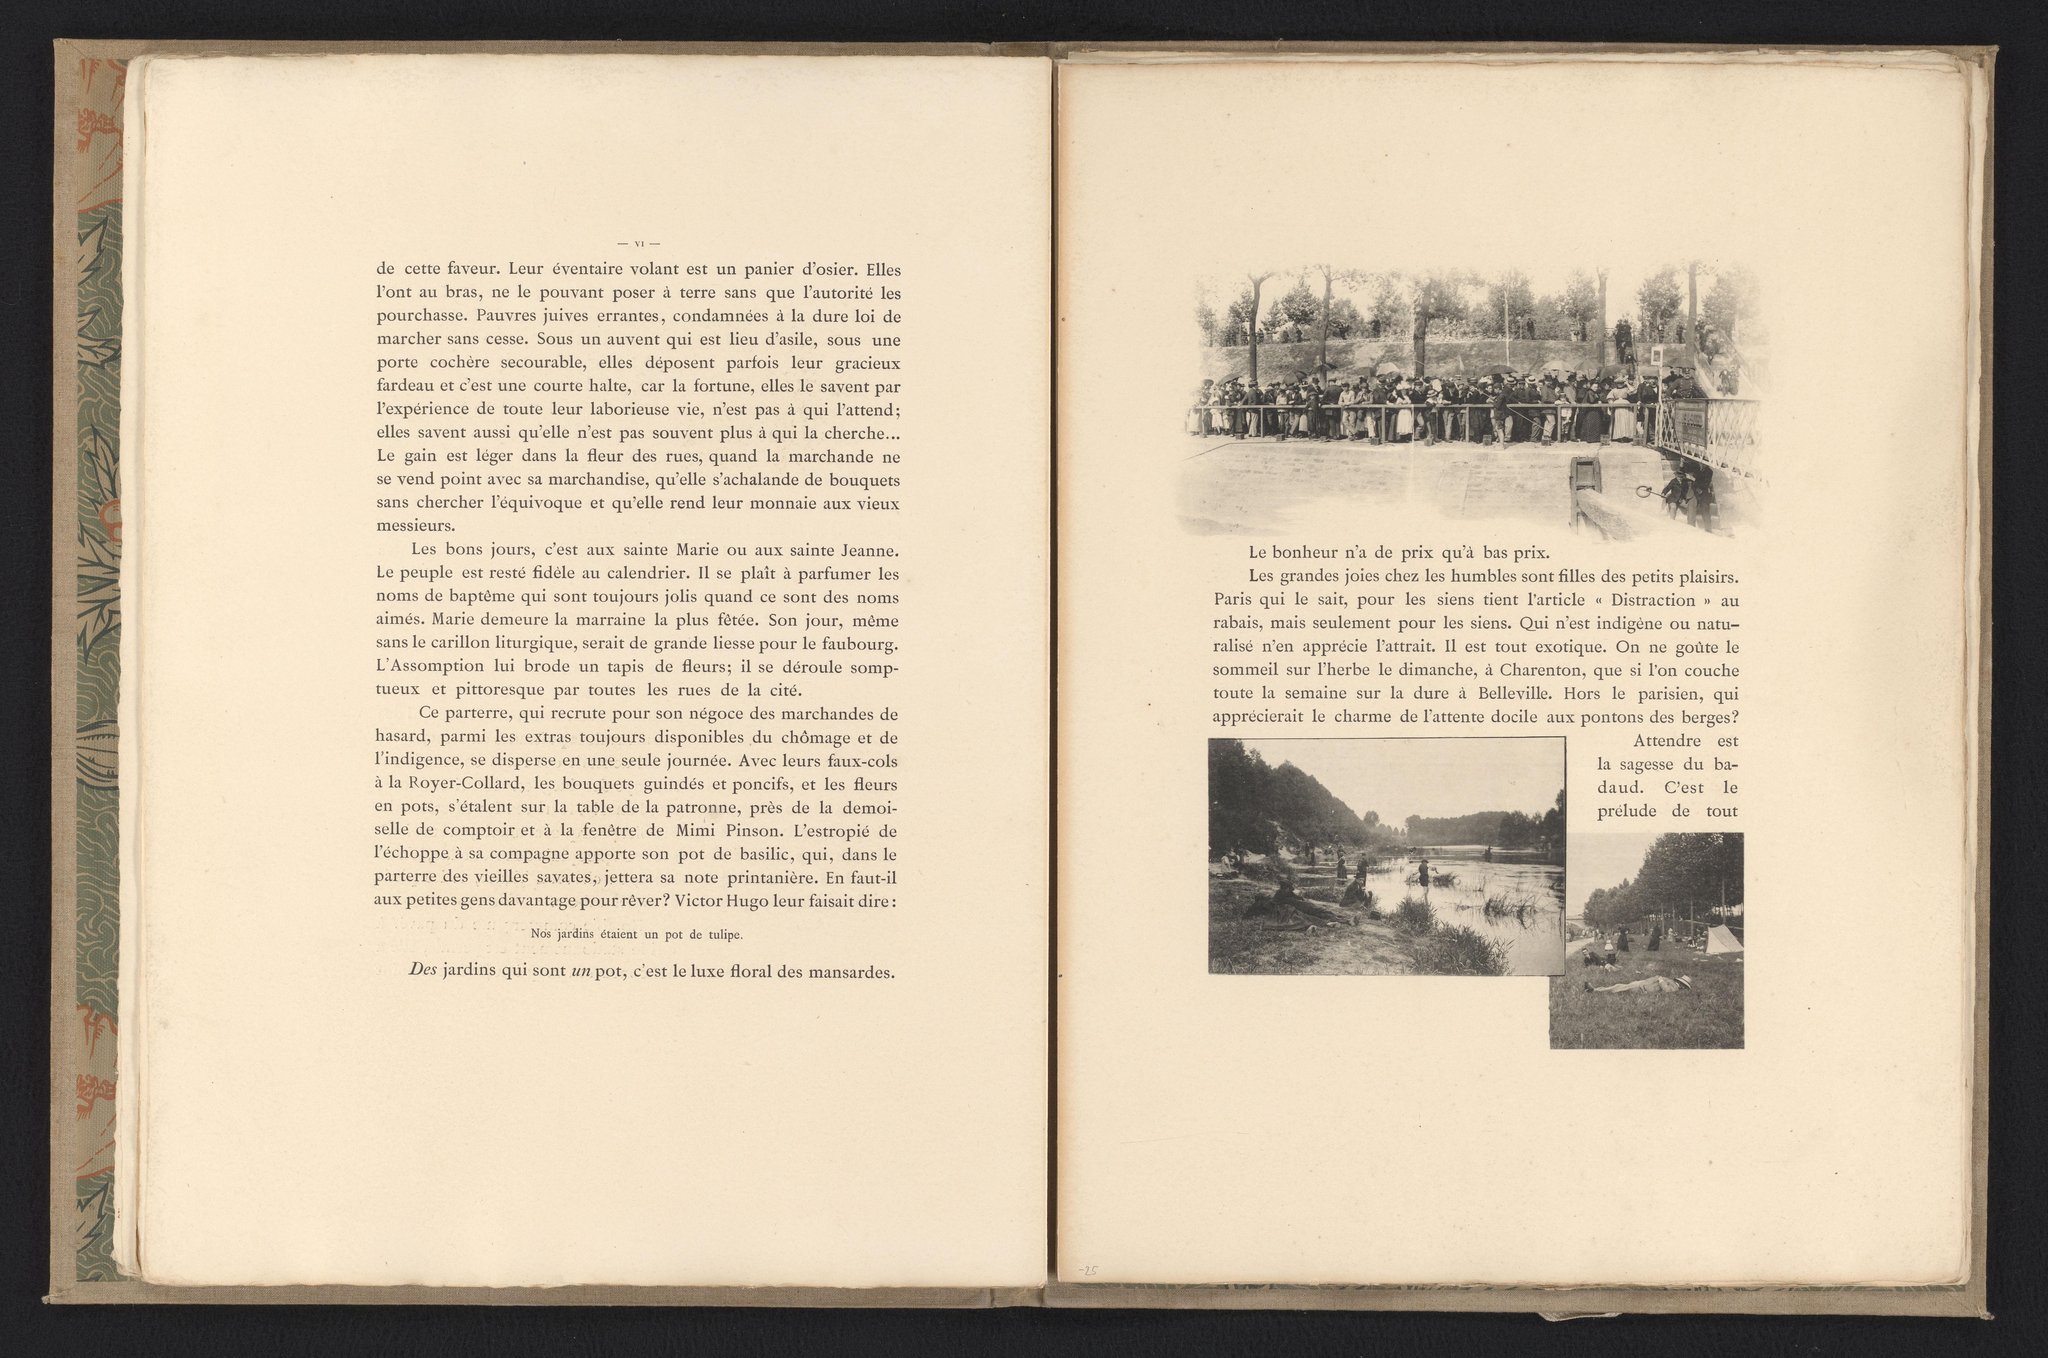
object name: album leaf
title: Drie taferelen met Parijzenaren langs een kade of oever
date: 1896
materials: paper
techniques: photograph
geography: châteaudun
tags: river bank, quay, paris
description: Prenten op drieënveertigste ongenummerde pagina.